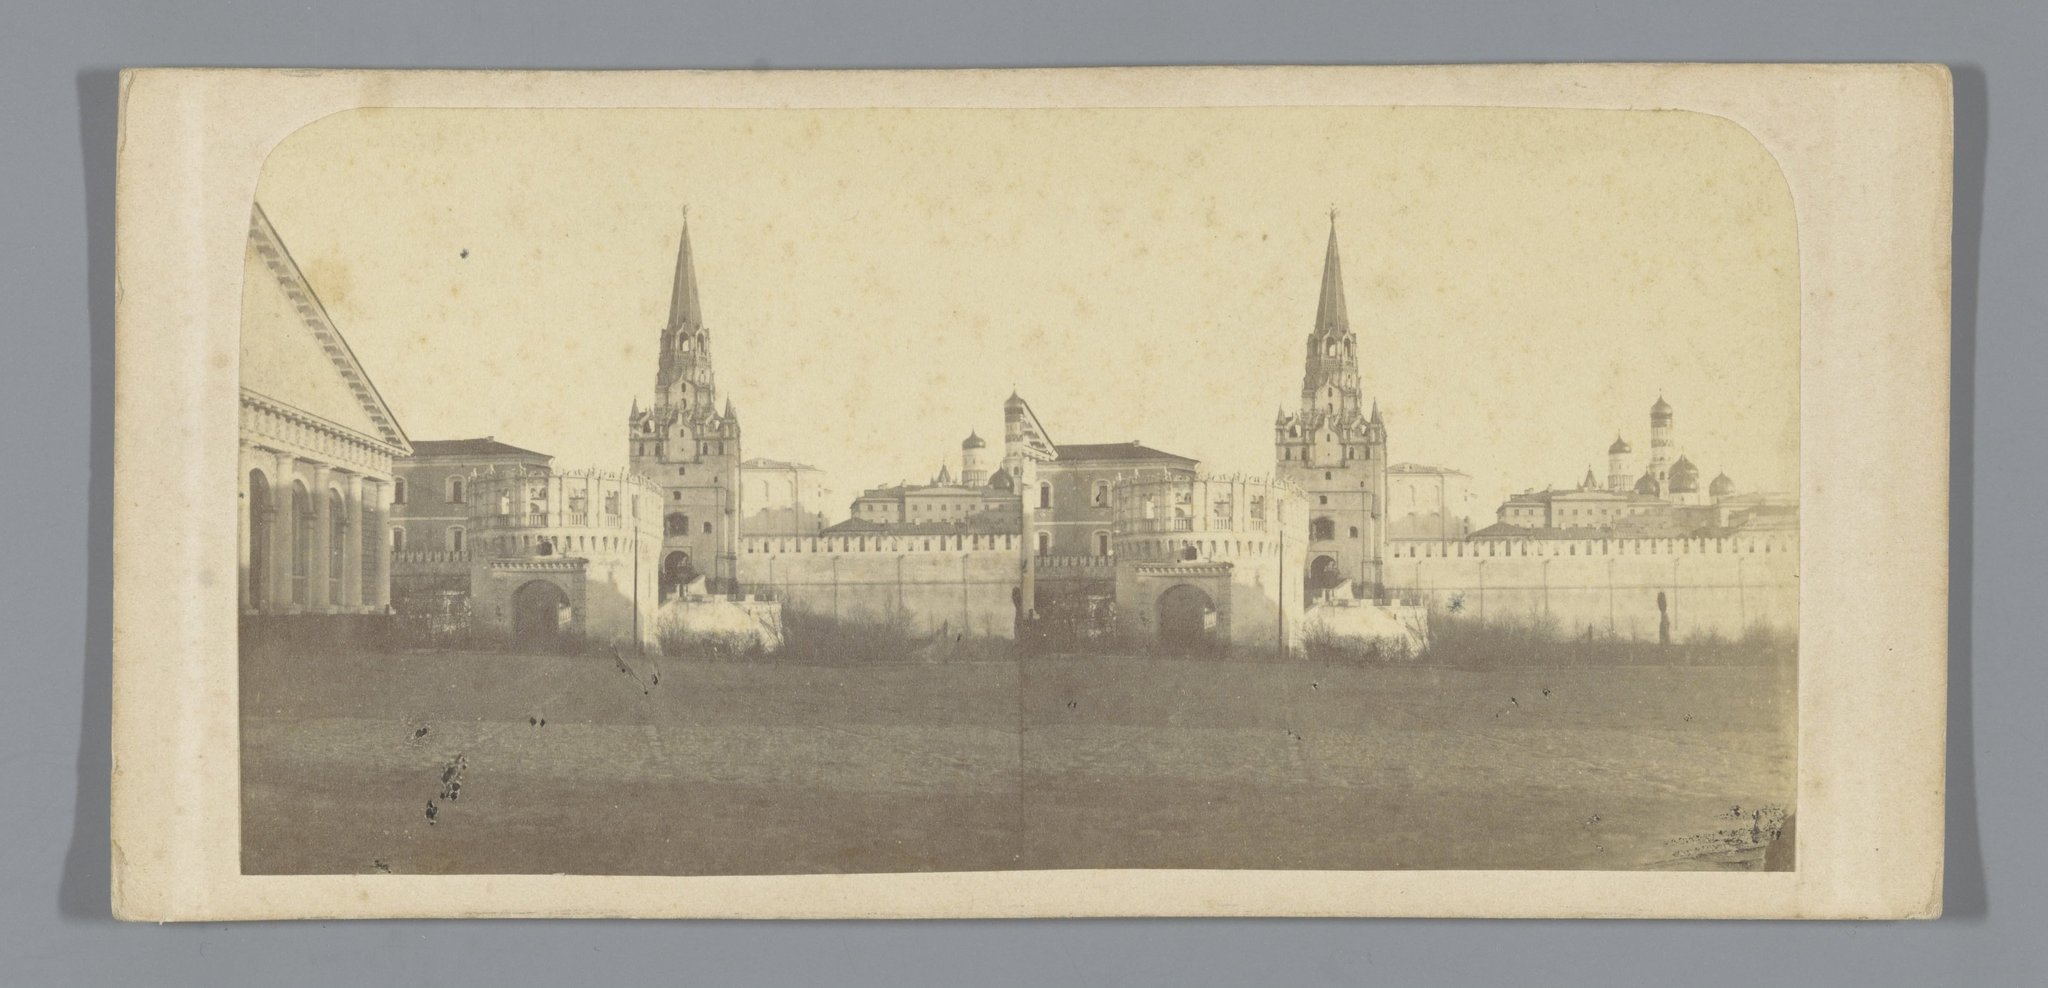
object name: stereograph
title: Poort naar het Kremlin in Moskou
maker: Anonymous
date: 1850-1880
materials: cardboard, photographic support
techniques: albumen print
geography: moscow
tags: gate ~ fortified city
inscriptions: inscription: ‘Moscou, Porte sacrée (Kremlin)’